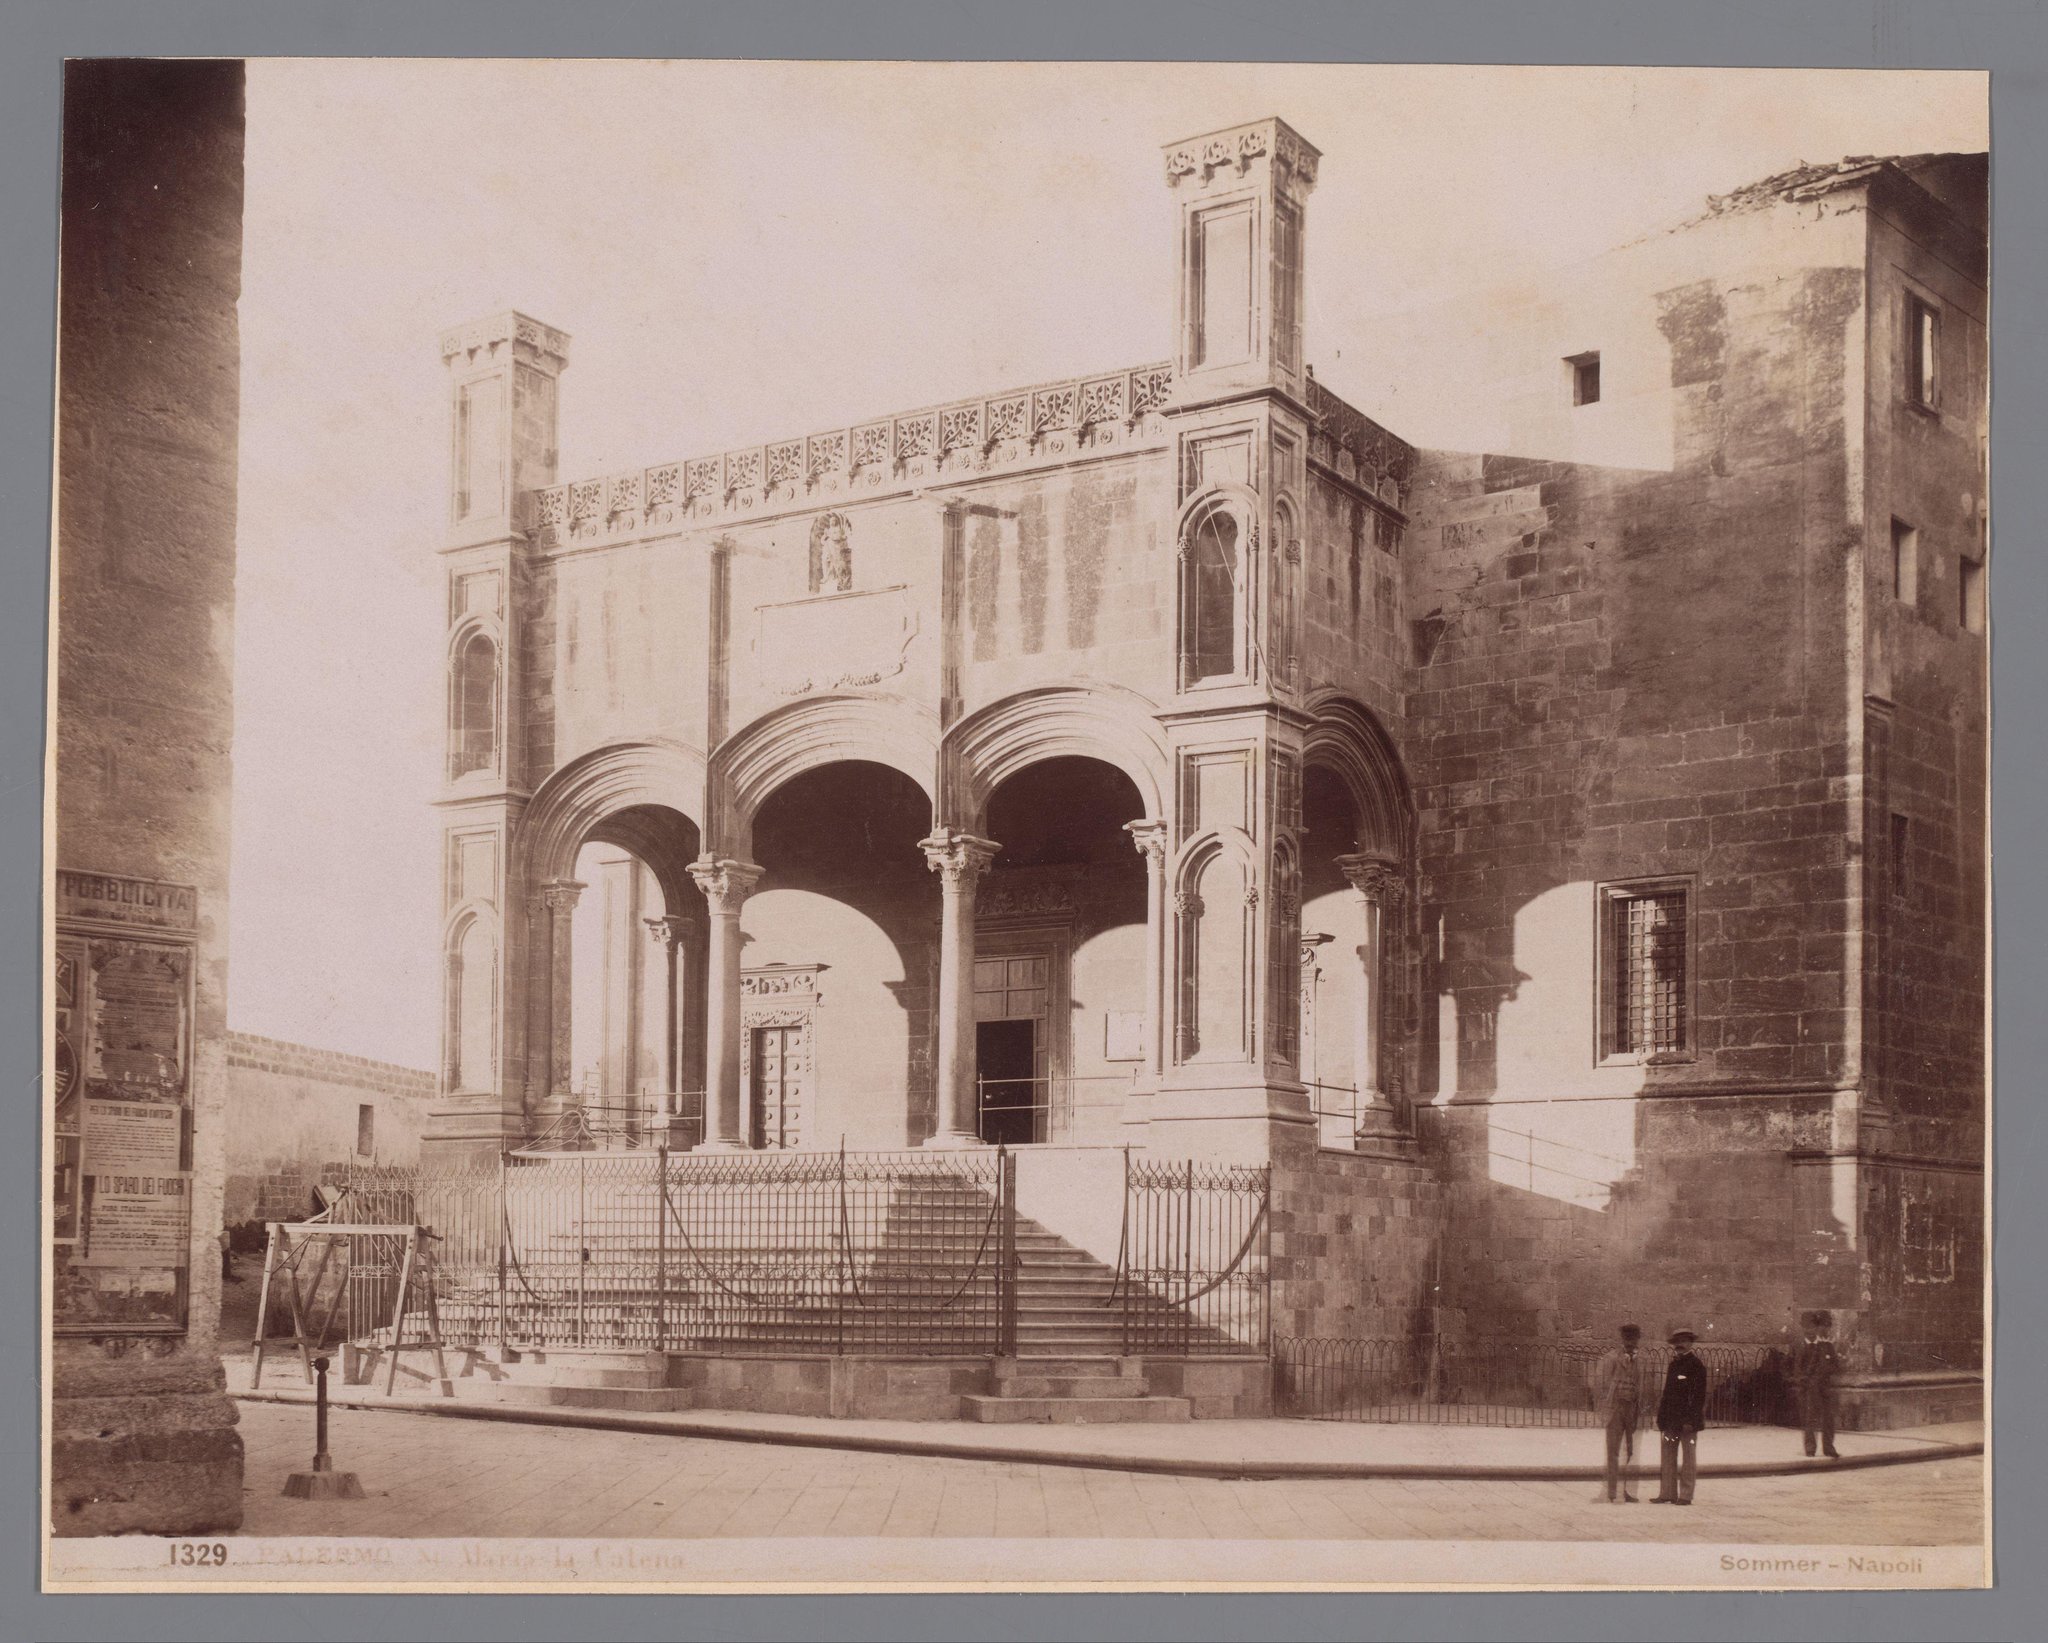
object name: photograph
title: Sa Maria da Catena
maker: giorgio sommer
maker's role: fotograaf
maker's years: 1834-1914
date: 1857-1914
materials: cardboard, paper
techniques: albumen print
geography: palermo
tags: church (exterior)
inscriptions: number: ‘1329’